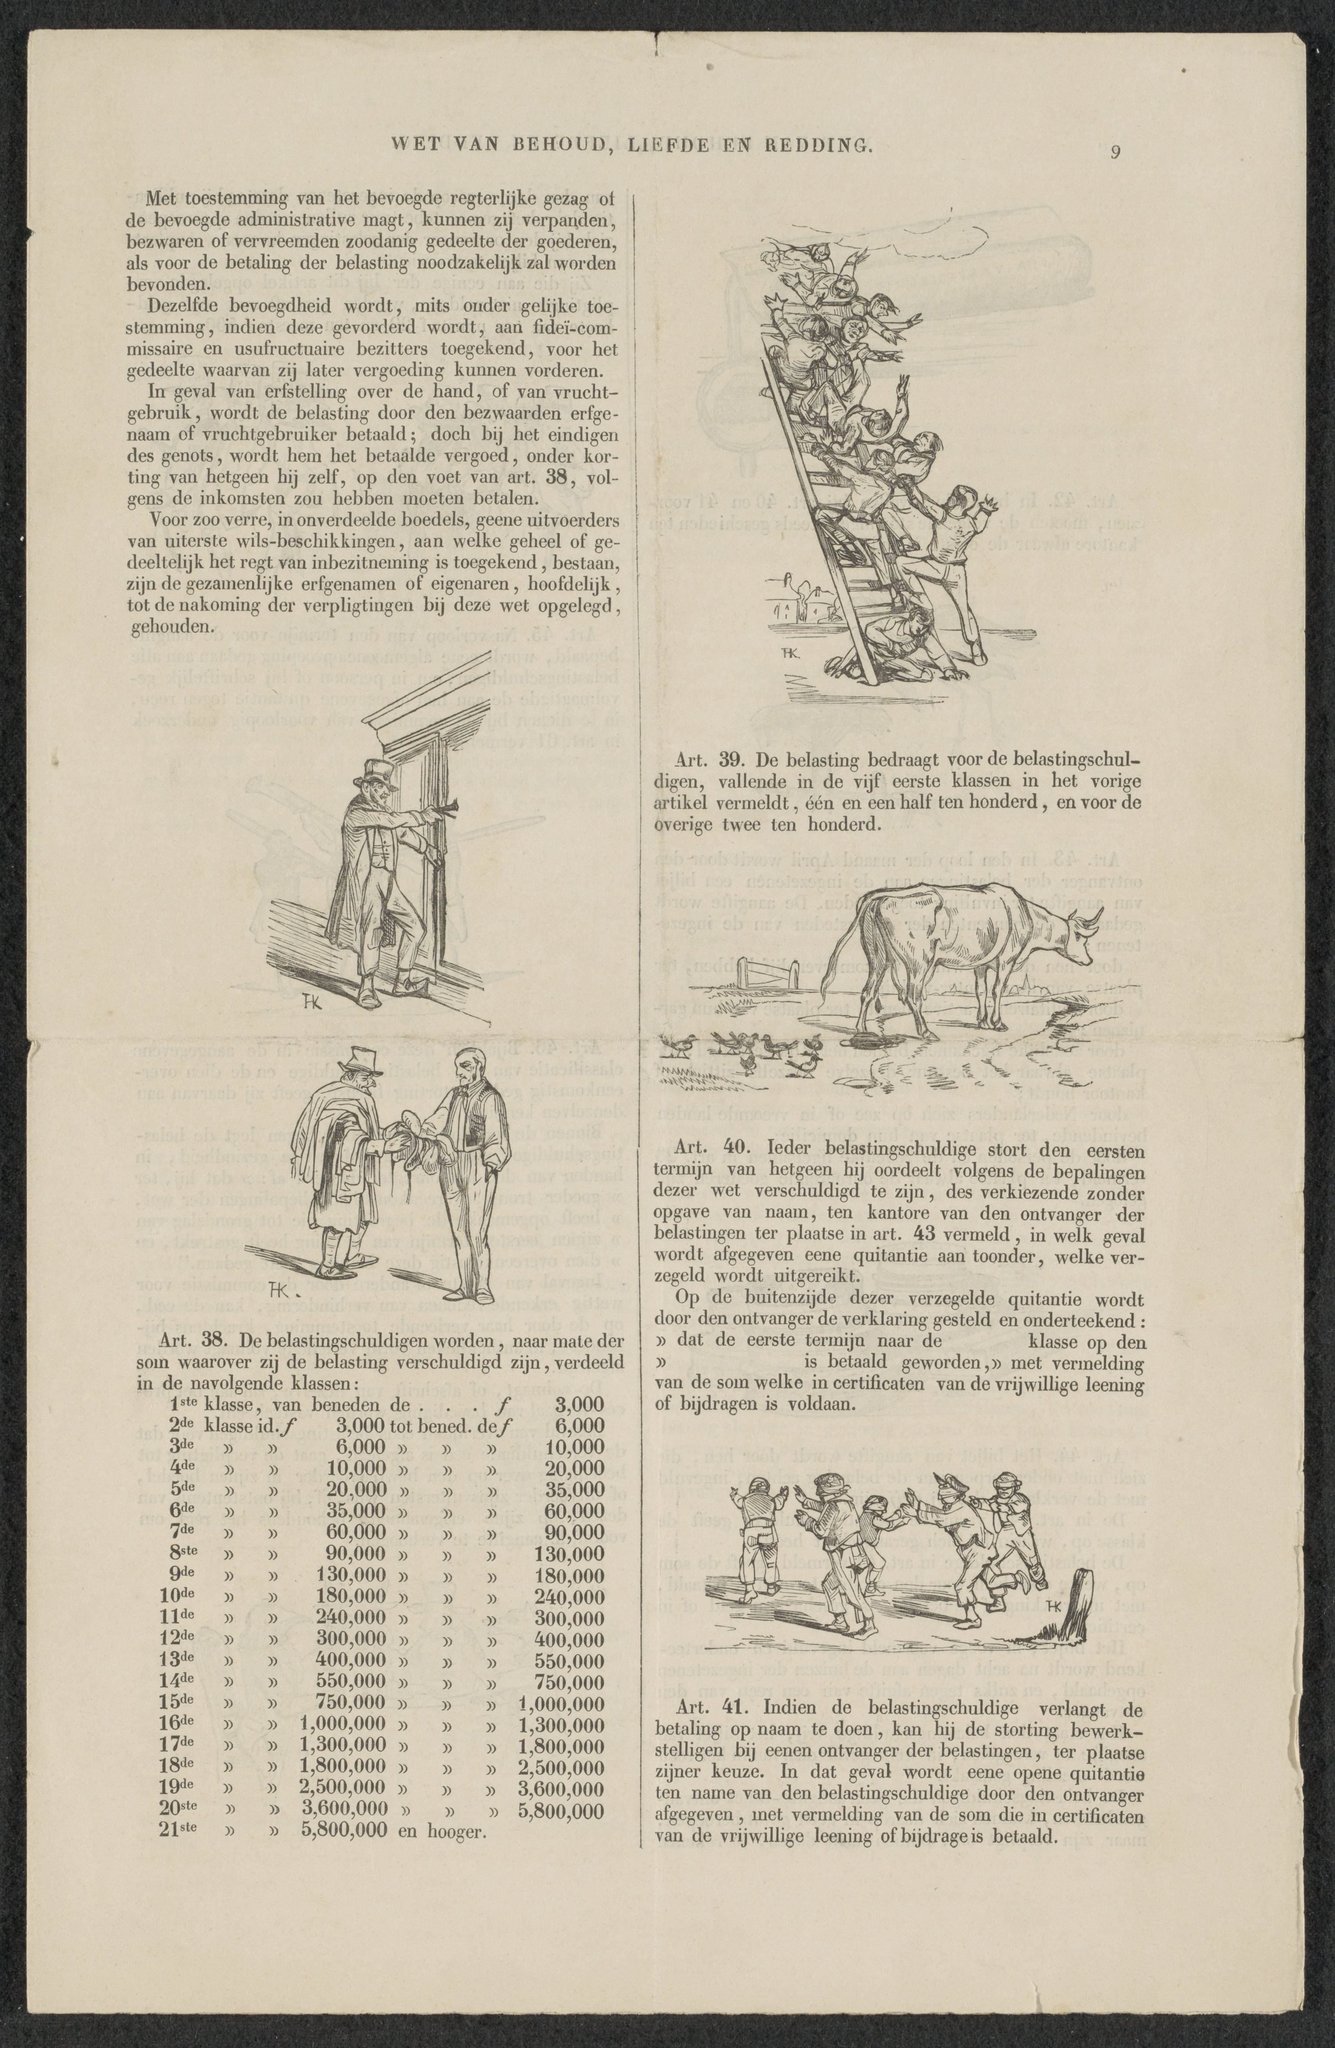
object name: print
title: Herdruk van de satire op de aansporing tot deelneming in de (zogenaamde) vrijwillige 3% geldlening van 1844 (blad 9)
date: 1844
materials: paper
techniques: letterpress printing, engraving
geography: netherlands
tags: amsterdam, the hague, floris adriaan van hall, organization of trade and finance, taxes and financial administration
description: Bladzijde 9 met artikels 38-41 van het 'Vermeerderd, Verbeterd en de Volmaaktheid Overtreffend Nieuw Ontwerp van Wet van Behoud, Liefde en Redding'. Een enigszins aaangepaste herdruk van satire in zestien bladzijden op de aansporing tot deelneming in de (zogenaamde) vrijwillige 3% geldlening uitgeschreven in maart 1844 door minister F.A. van Hall. Voorzijde van een dubbelgevouwen blad bedrukt op alle zijden.